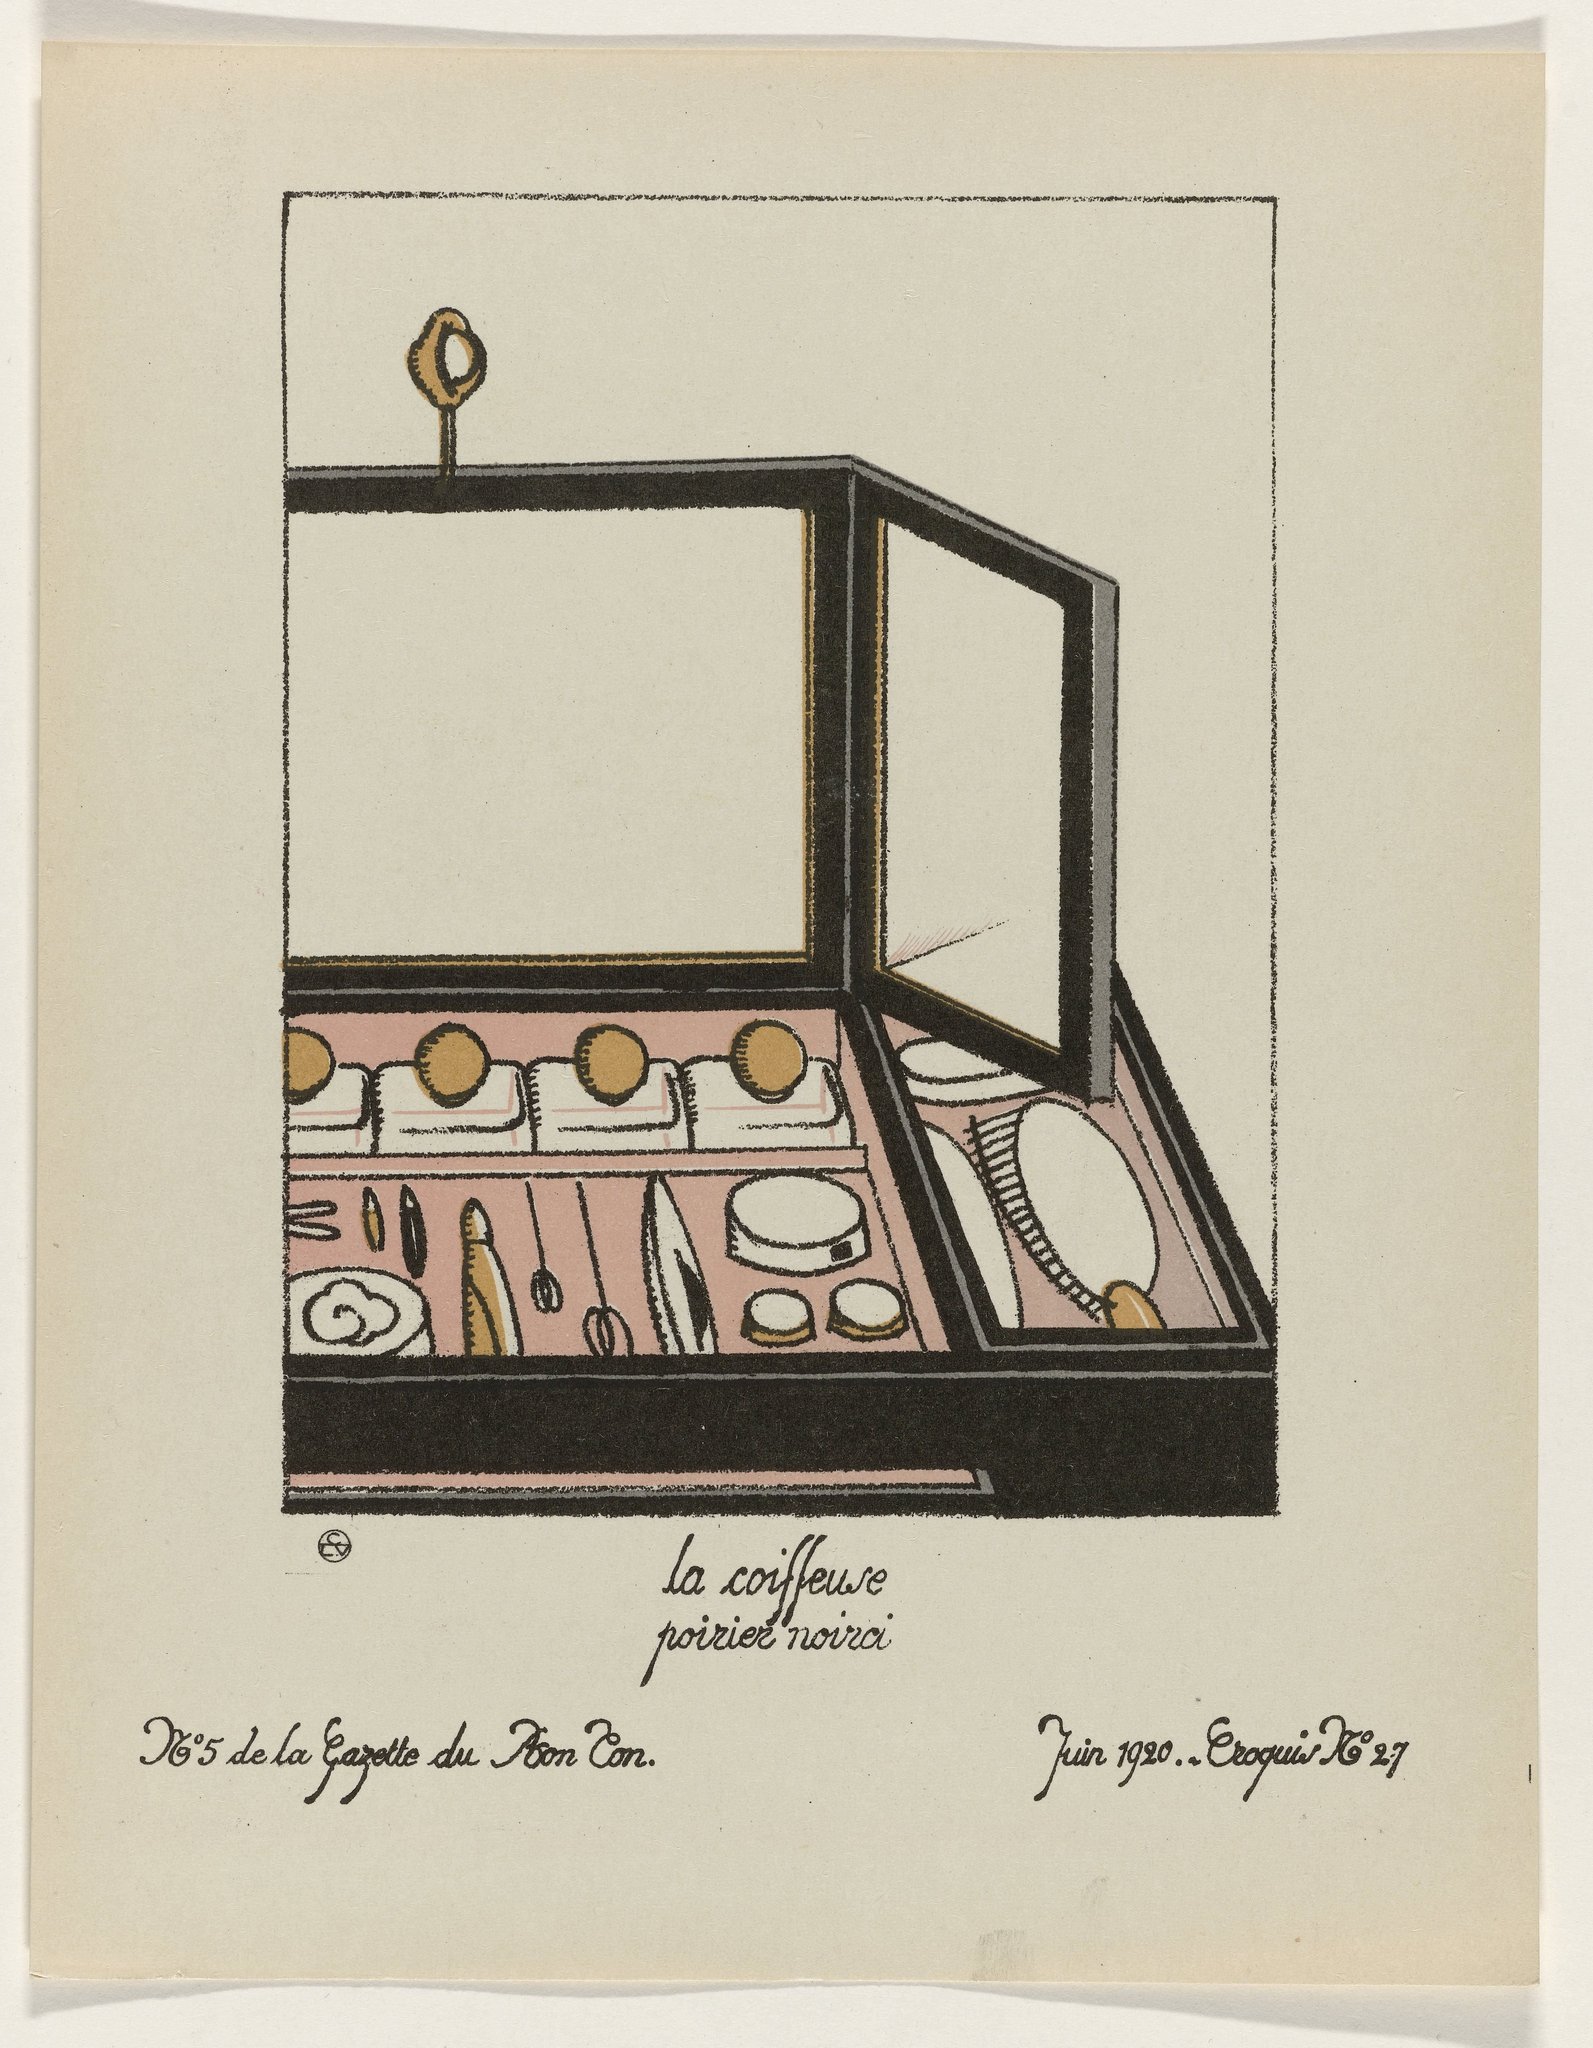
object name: fashion print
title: Gazette du Bon Ton, 1920 - No. 5 : La coiffeuse / poirier noirci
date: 1920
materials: paper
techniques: lithograph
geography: paris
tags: comb, brush and other tools (care of the hair) - aa - ~ women, fashion plates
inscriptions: date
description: Een kaptafel. De prent maakt deel uit van een serie van vier schetsen getiteld 'Aménagement d'une loge d'actrice'. Croquis No. 27 uit Gazette du Bon Ton 1920, No. 5. Uitleg over de meubels op pagina "Explication des Planches".